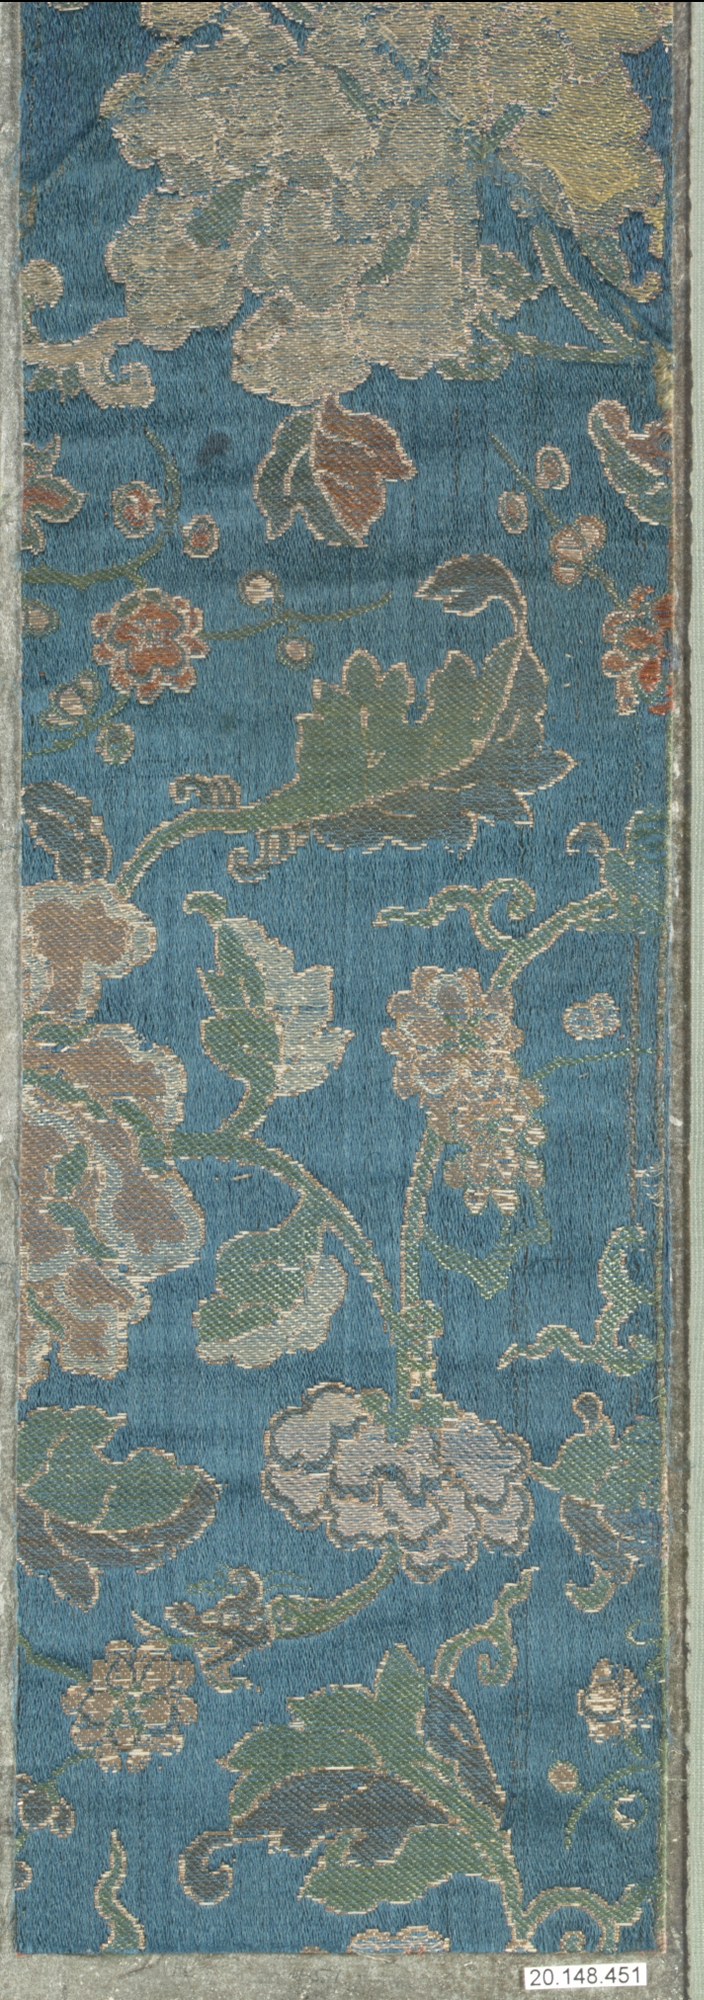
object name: piece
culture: chinese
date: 1701-1800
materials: silk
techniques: compound weave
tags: flowers,leaves